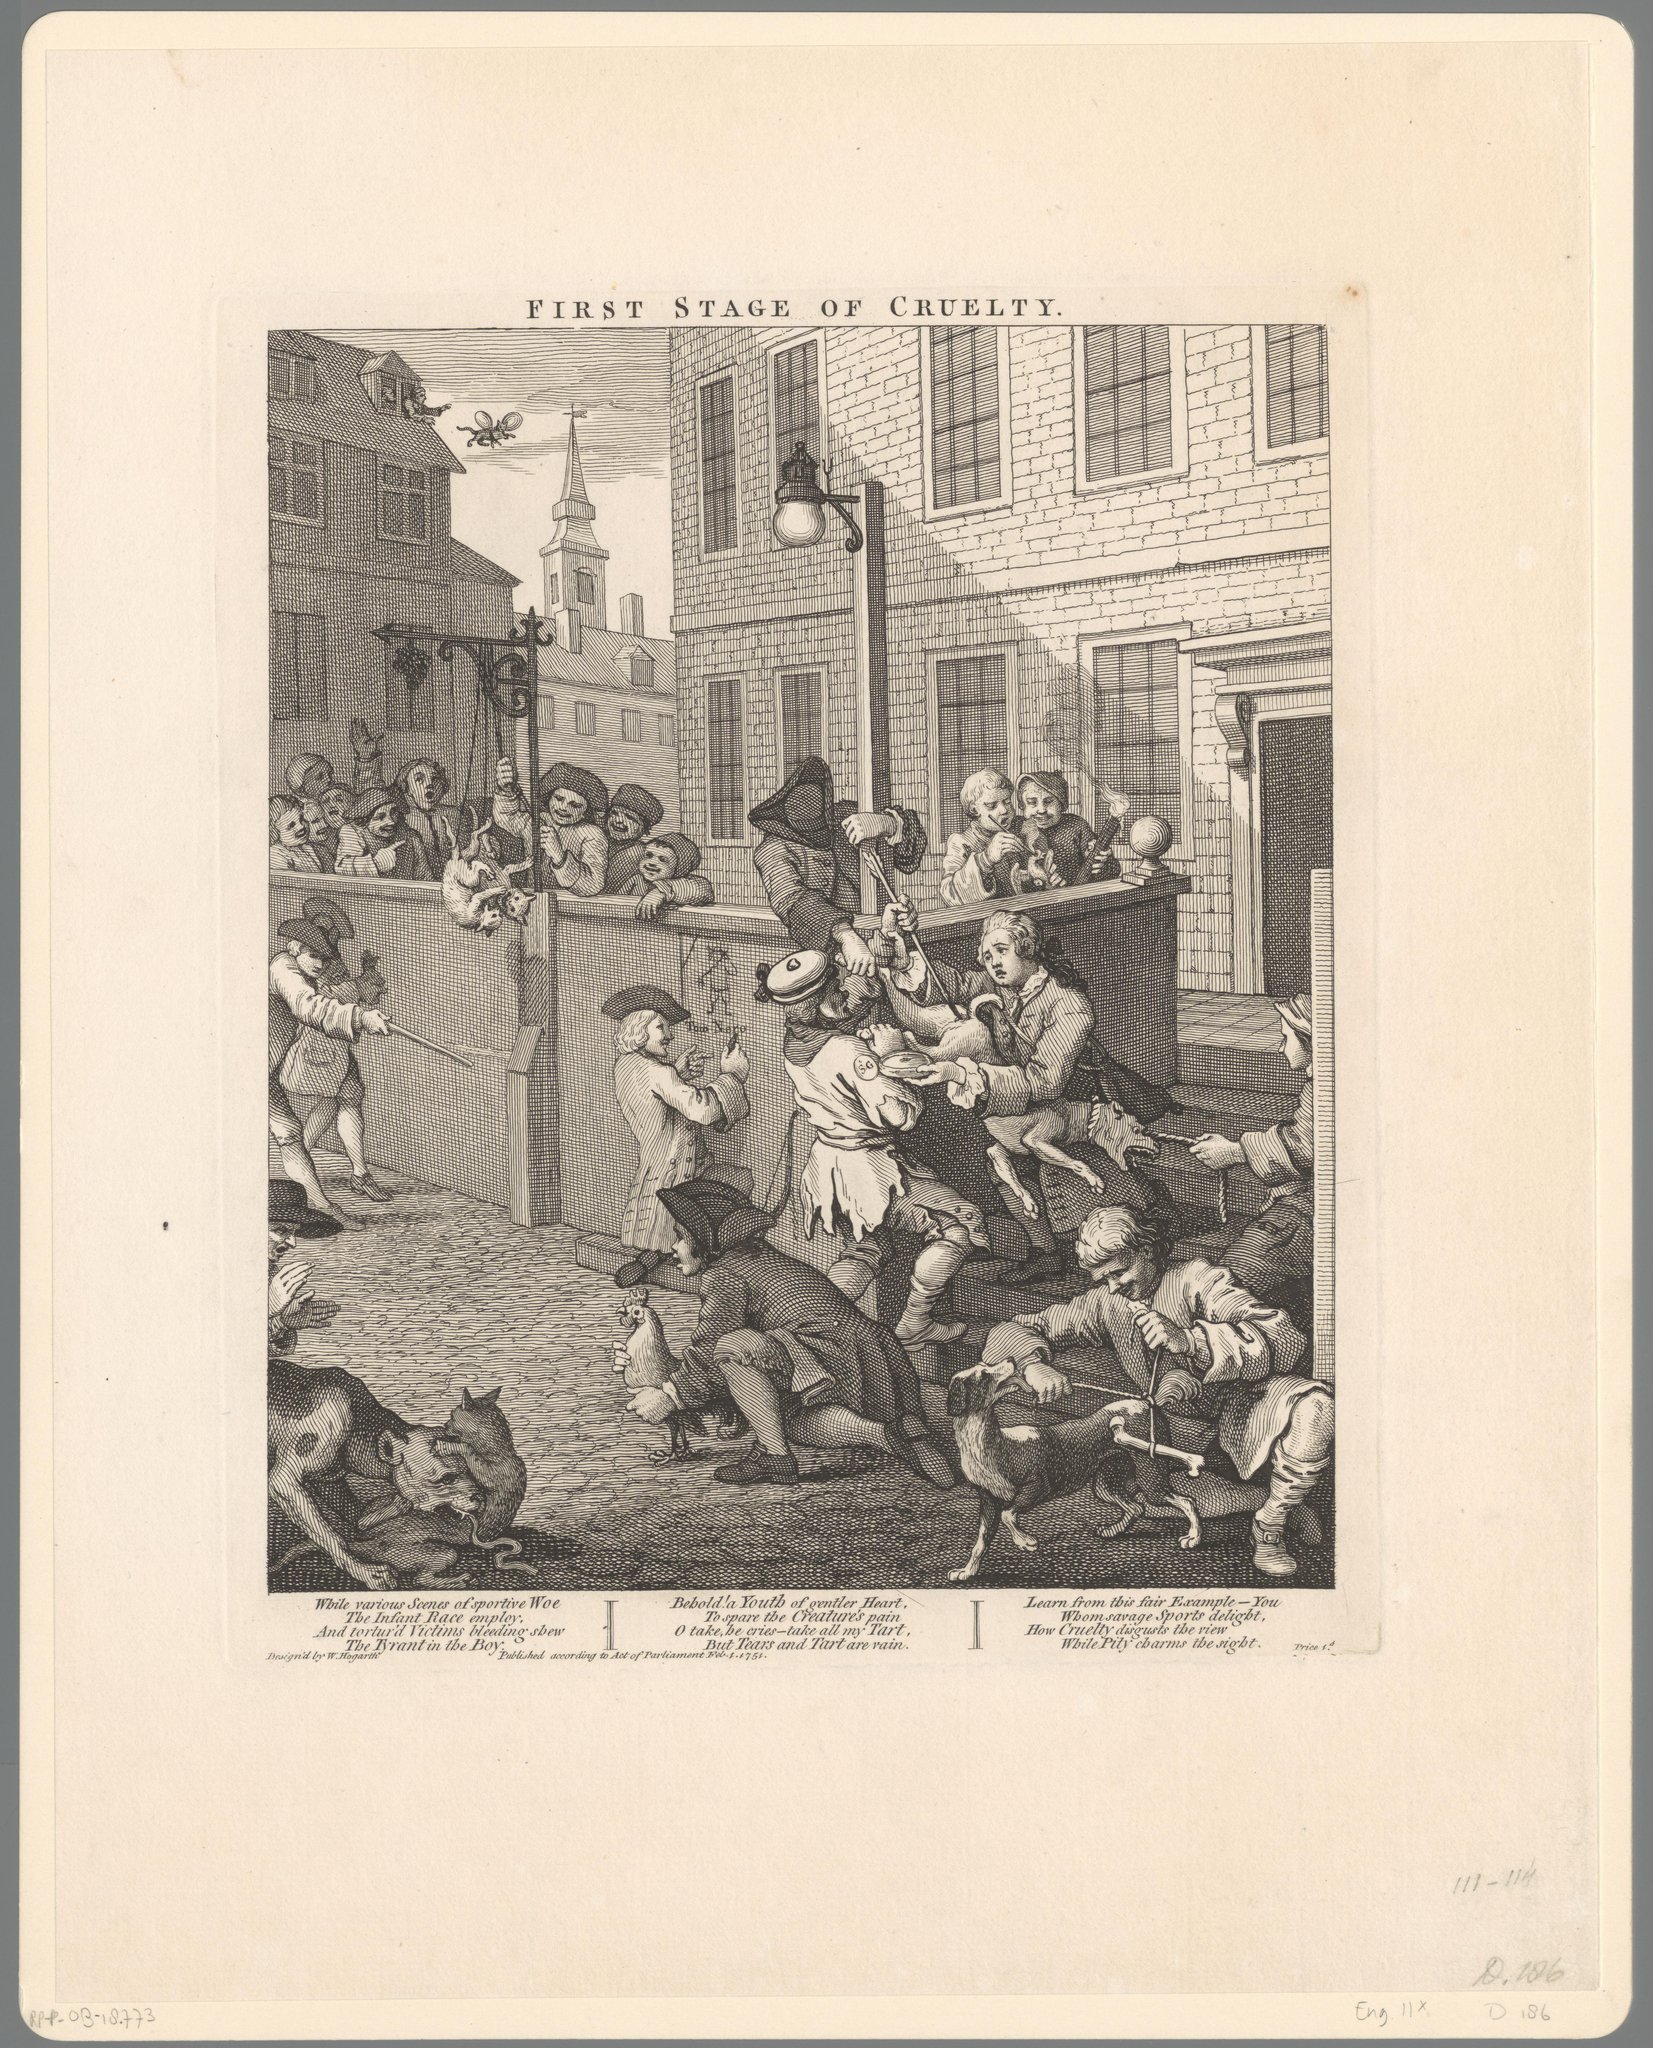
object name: print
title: Mishandeling van huisdieren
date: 1751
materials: paper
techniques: engraving, etching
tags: torture, domestic animals, kept in and outside the house, cruelty, ferocity; 'crudeltà', 'ferocità' (ripa)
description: Deze serie weergeeft vier stadia van wreedheid: bewuste, onbewuste en geplande wreedheid en sadisme. Hogarth verwijst naar de fictieve Tom Nero en zijn wrede gedachtegoed door in alle prenten impliciet of expliciet naar hem te verwijzen.